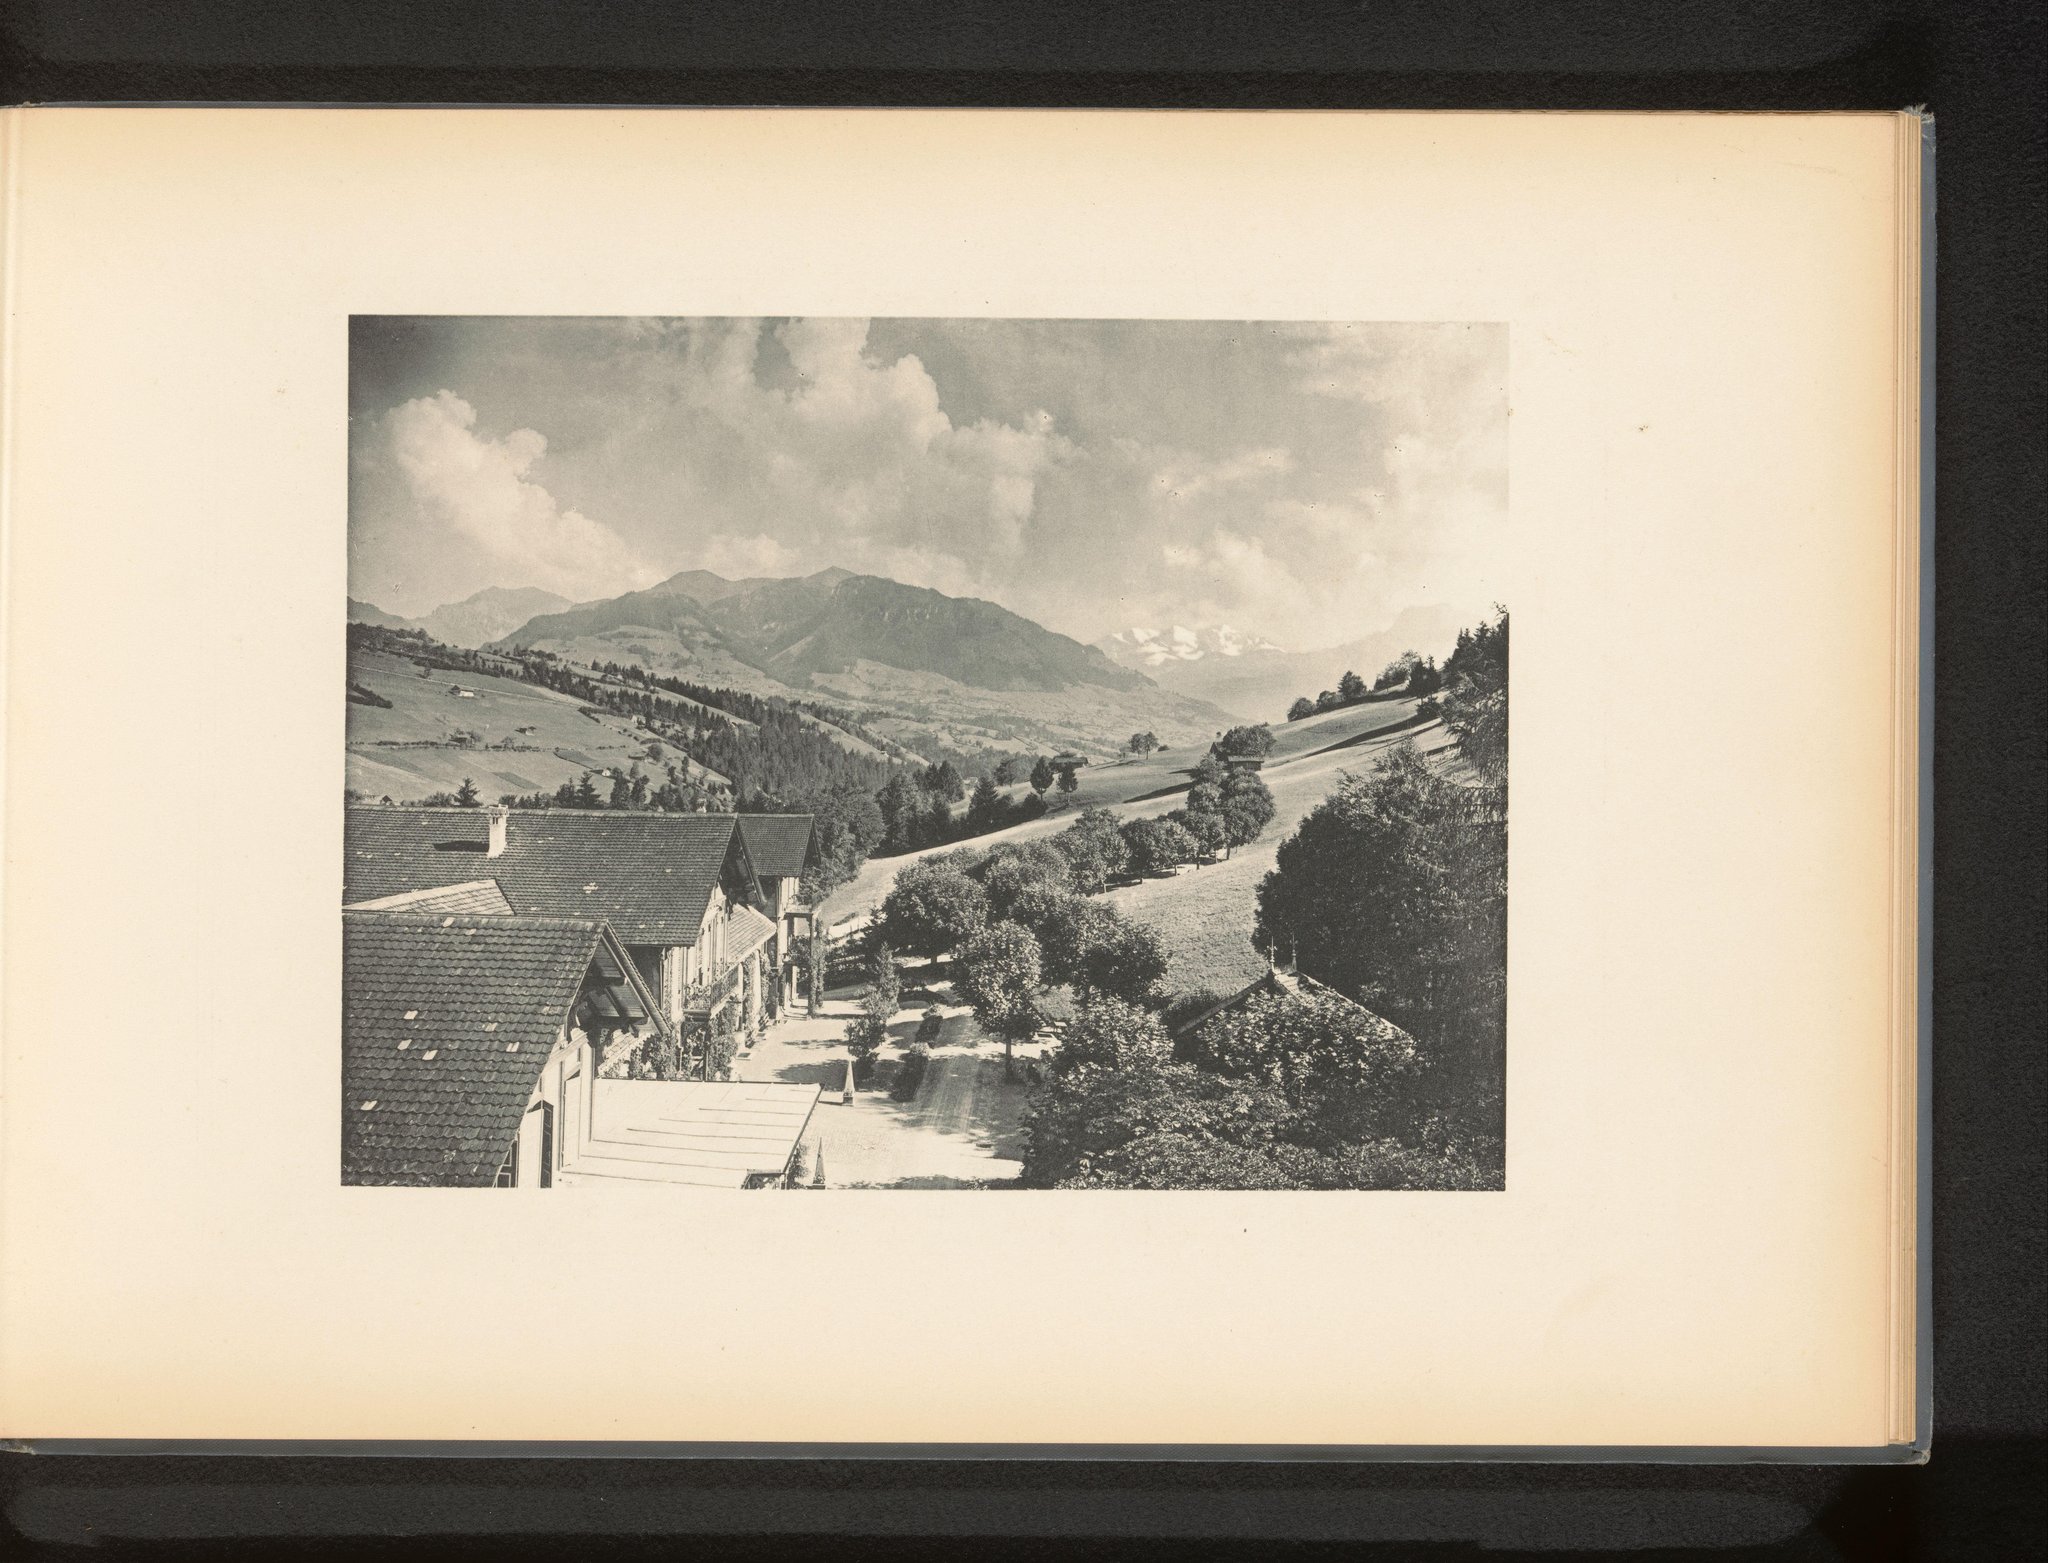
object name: page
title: Gezicht op de omgeving van Heustrich-les-bains bij Spiez, Zwitserland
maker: Anonymous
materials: paper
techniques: photograph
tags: prospect of village, silhouette of village, landscapes, mountains